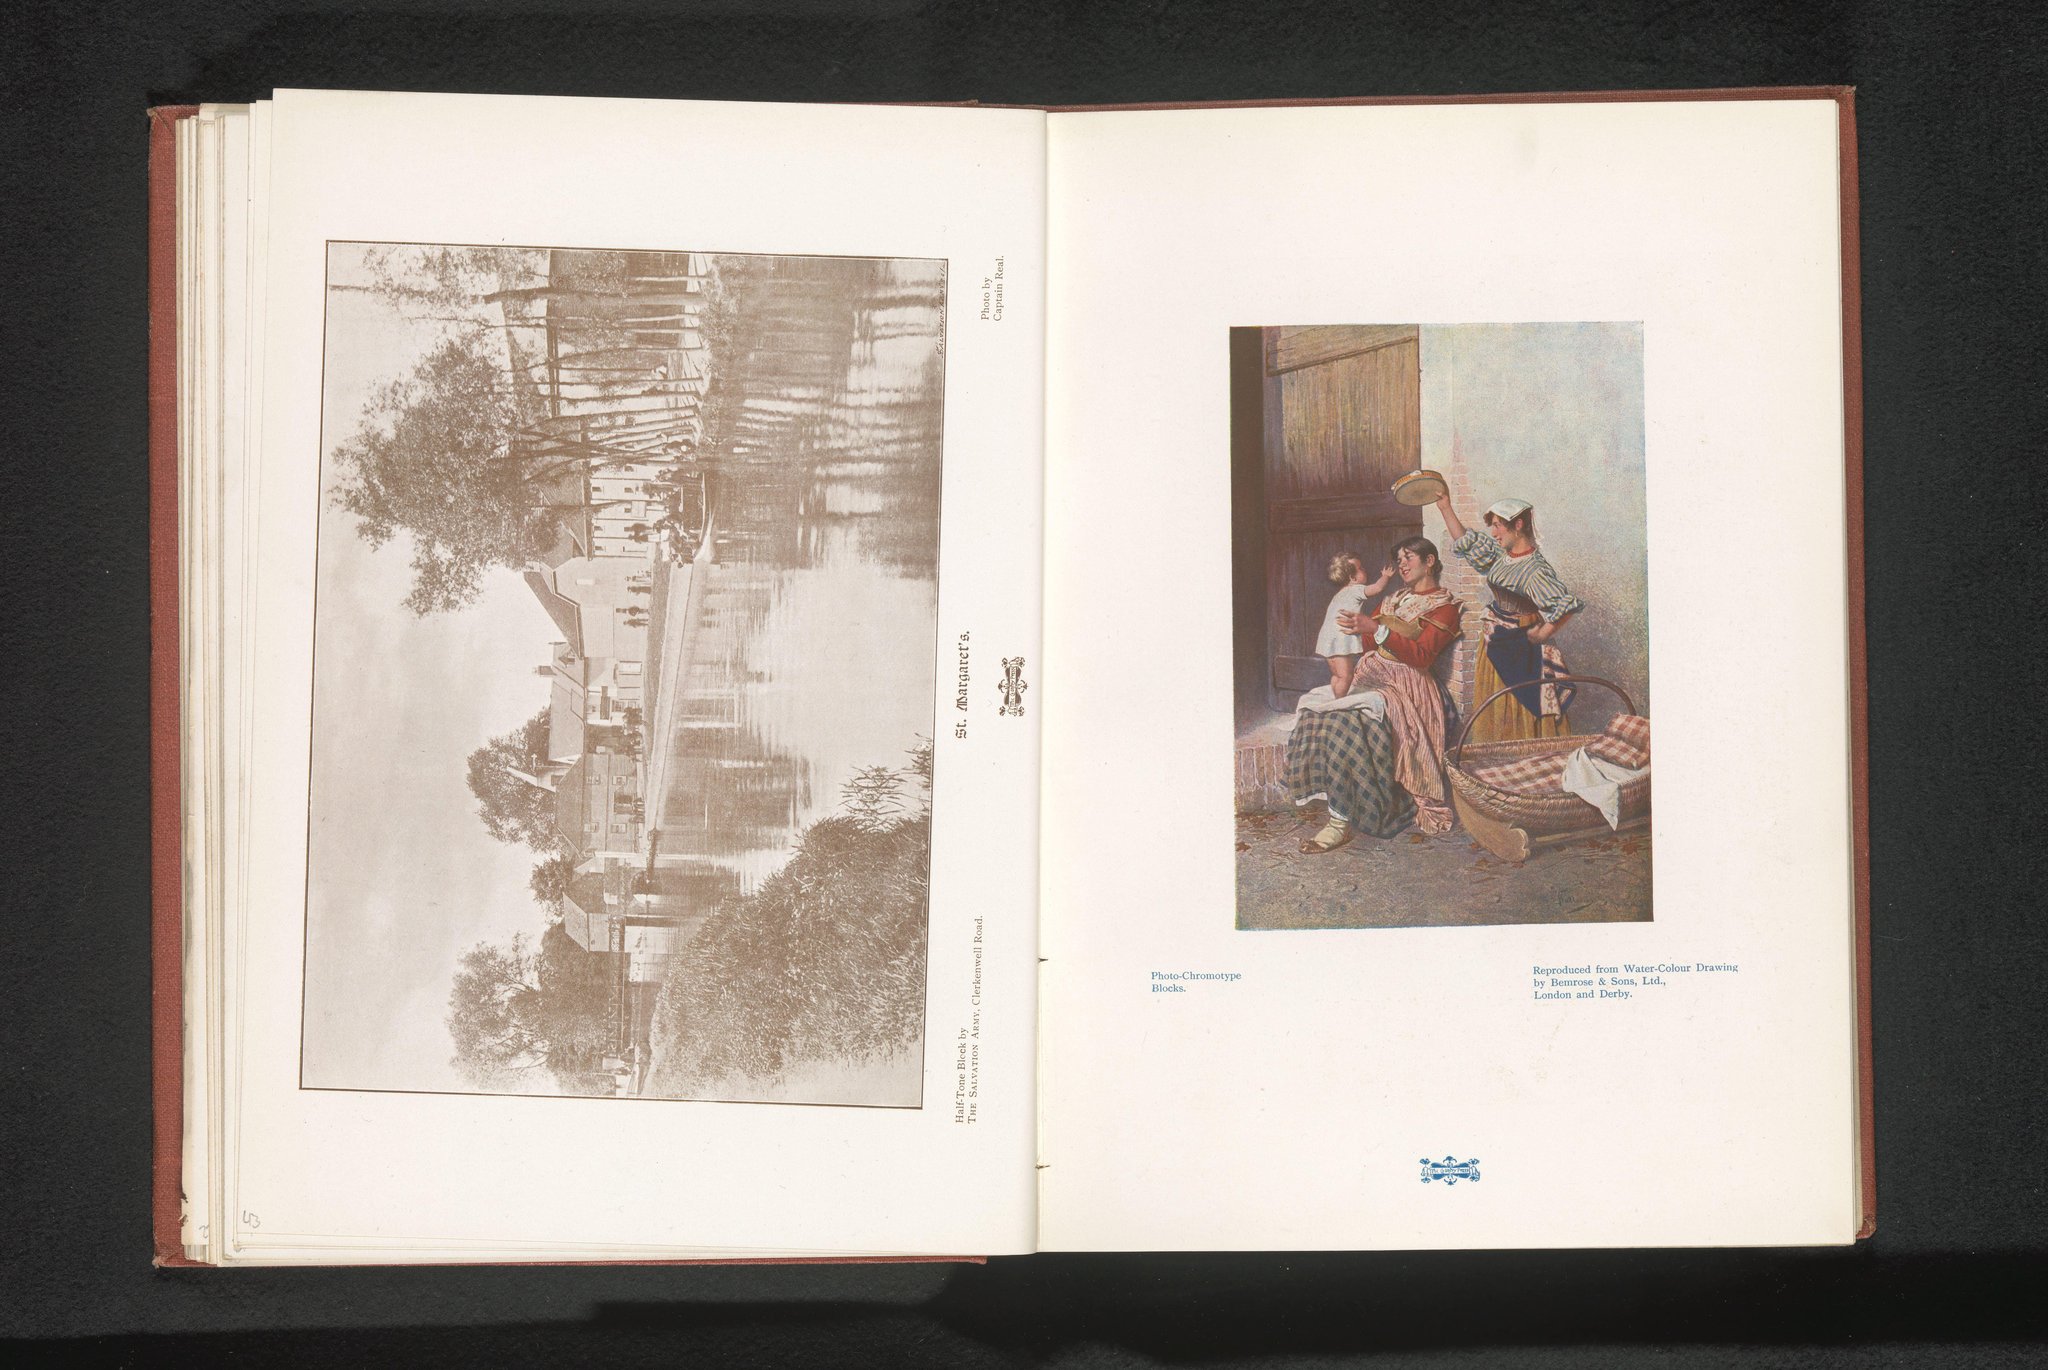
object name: page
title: St. Margaret's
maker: captain real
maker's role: fotograaf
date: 1895-1900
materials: paper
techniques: autotype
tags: village (+ city(-scape) with figures, staffage)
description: Prent op achtste ongenummerde pagina na pagina 32.